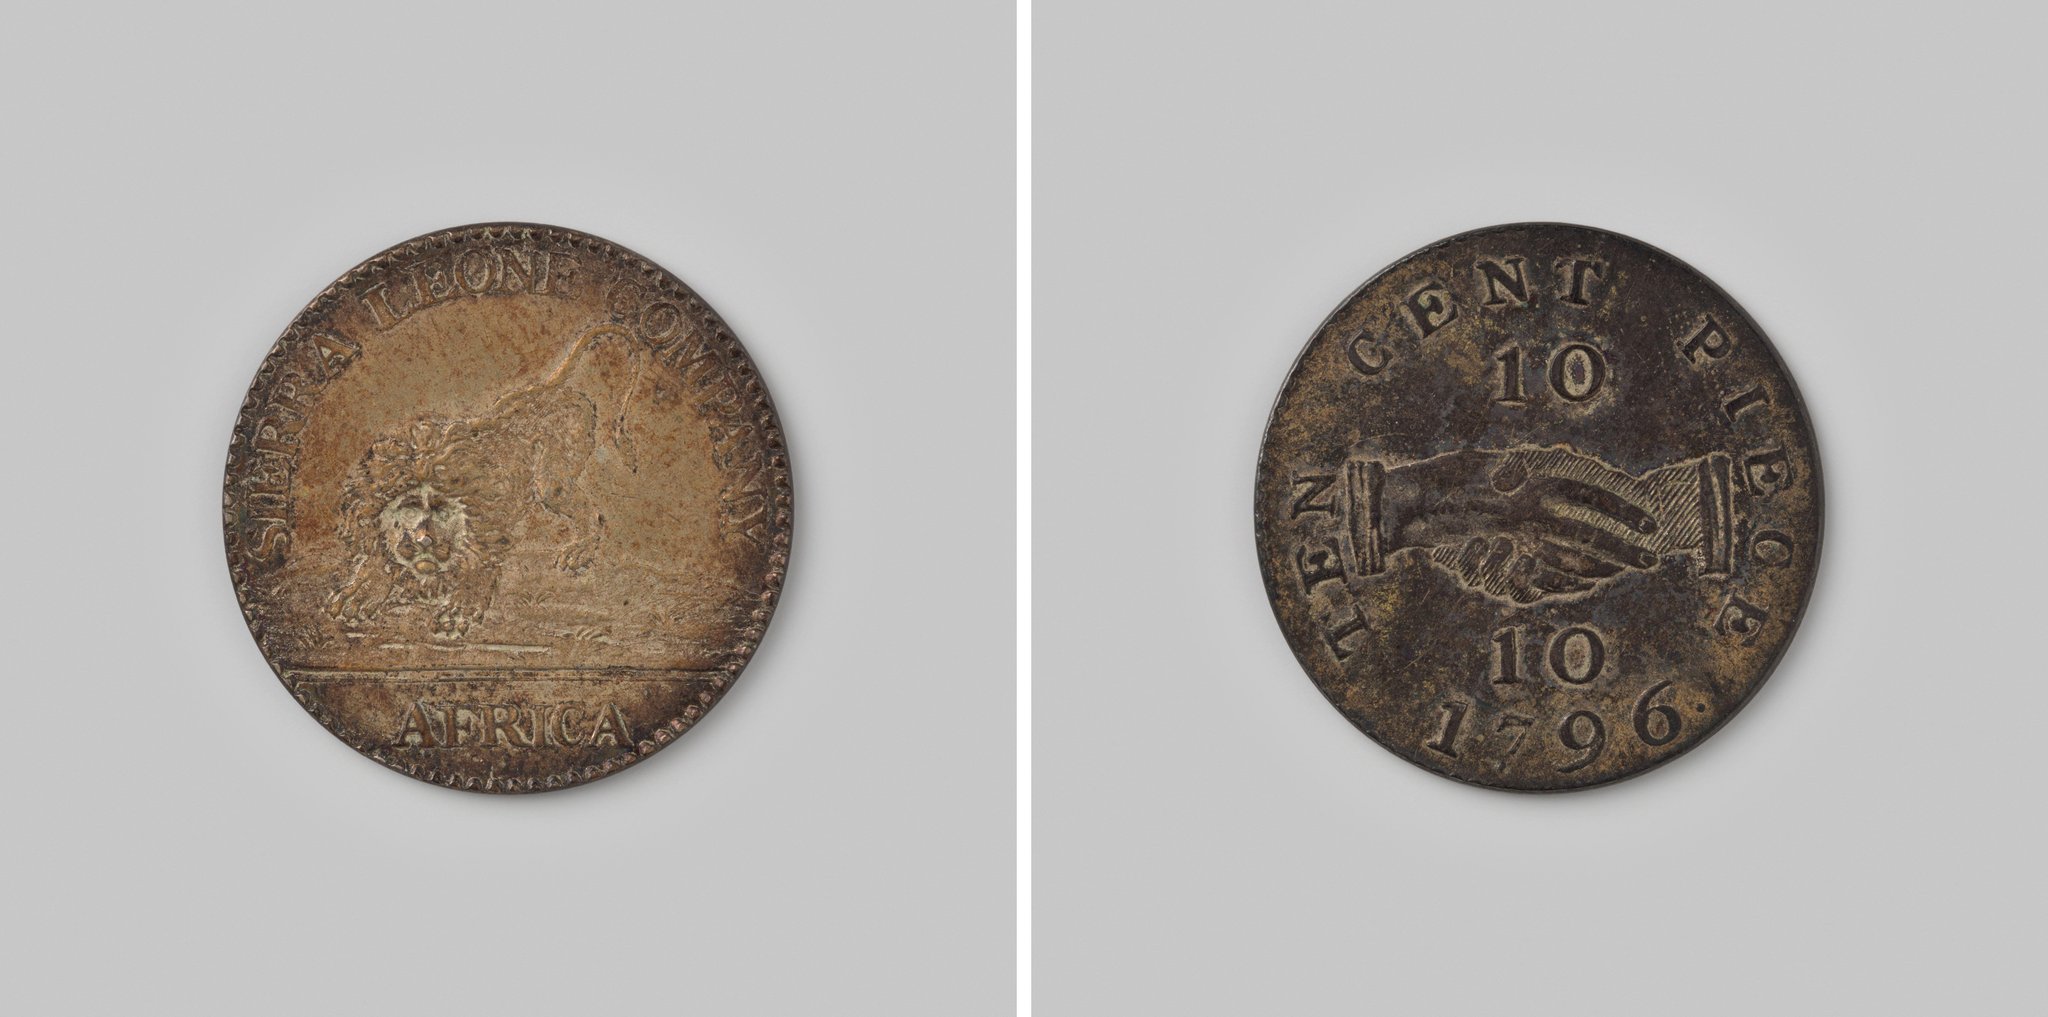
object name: coin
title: 10 cent uit Sierra Leone op naam van de Sierra Leone Company, 1796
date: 1796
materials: silver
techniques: striking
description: Zilveren munt. Voorzijde: aanziende leuw in aanvallende houding. Keerzijde: tussen tweemaal het cijfer: 10 twee ineen geslagen handen, de ene blank en de andere gearceerd. In het omschrift waarde-aanduiding: ten cent piece met onderaan het jaaratal. Gladde rand.